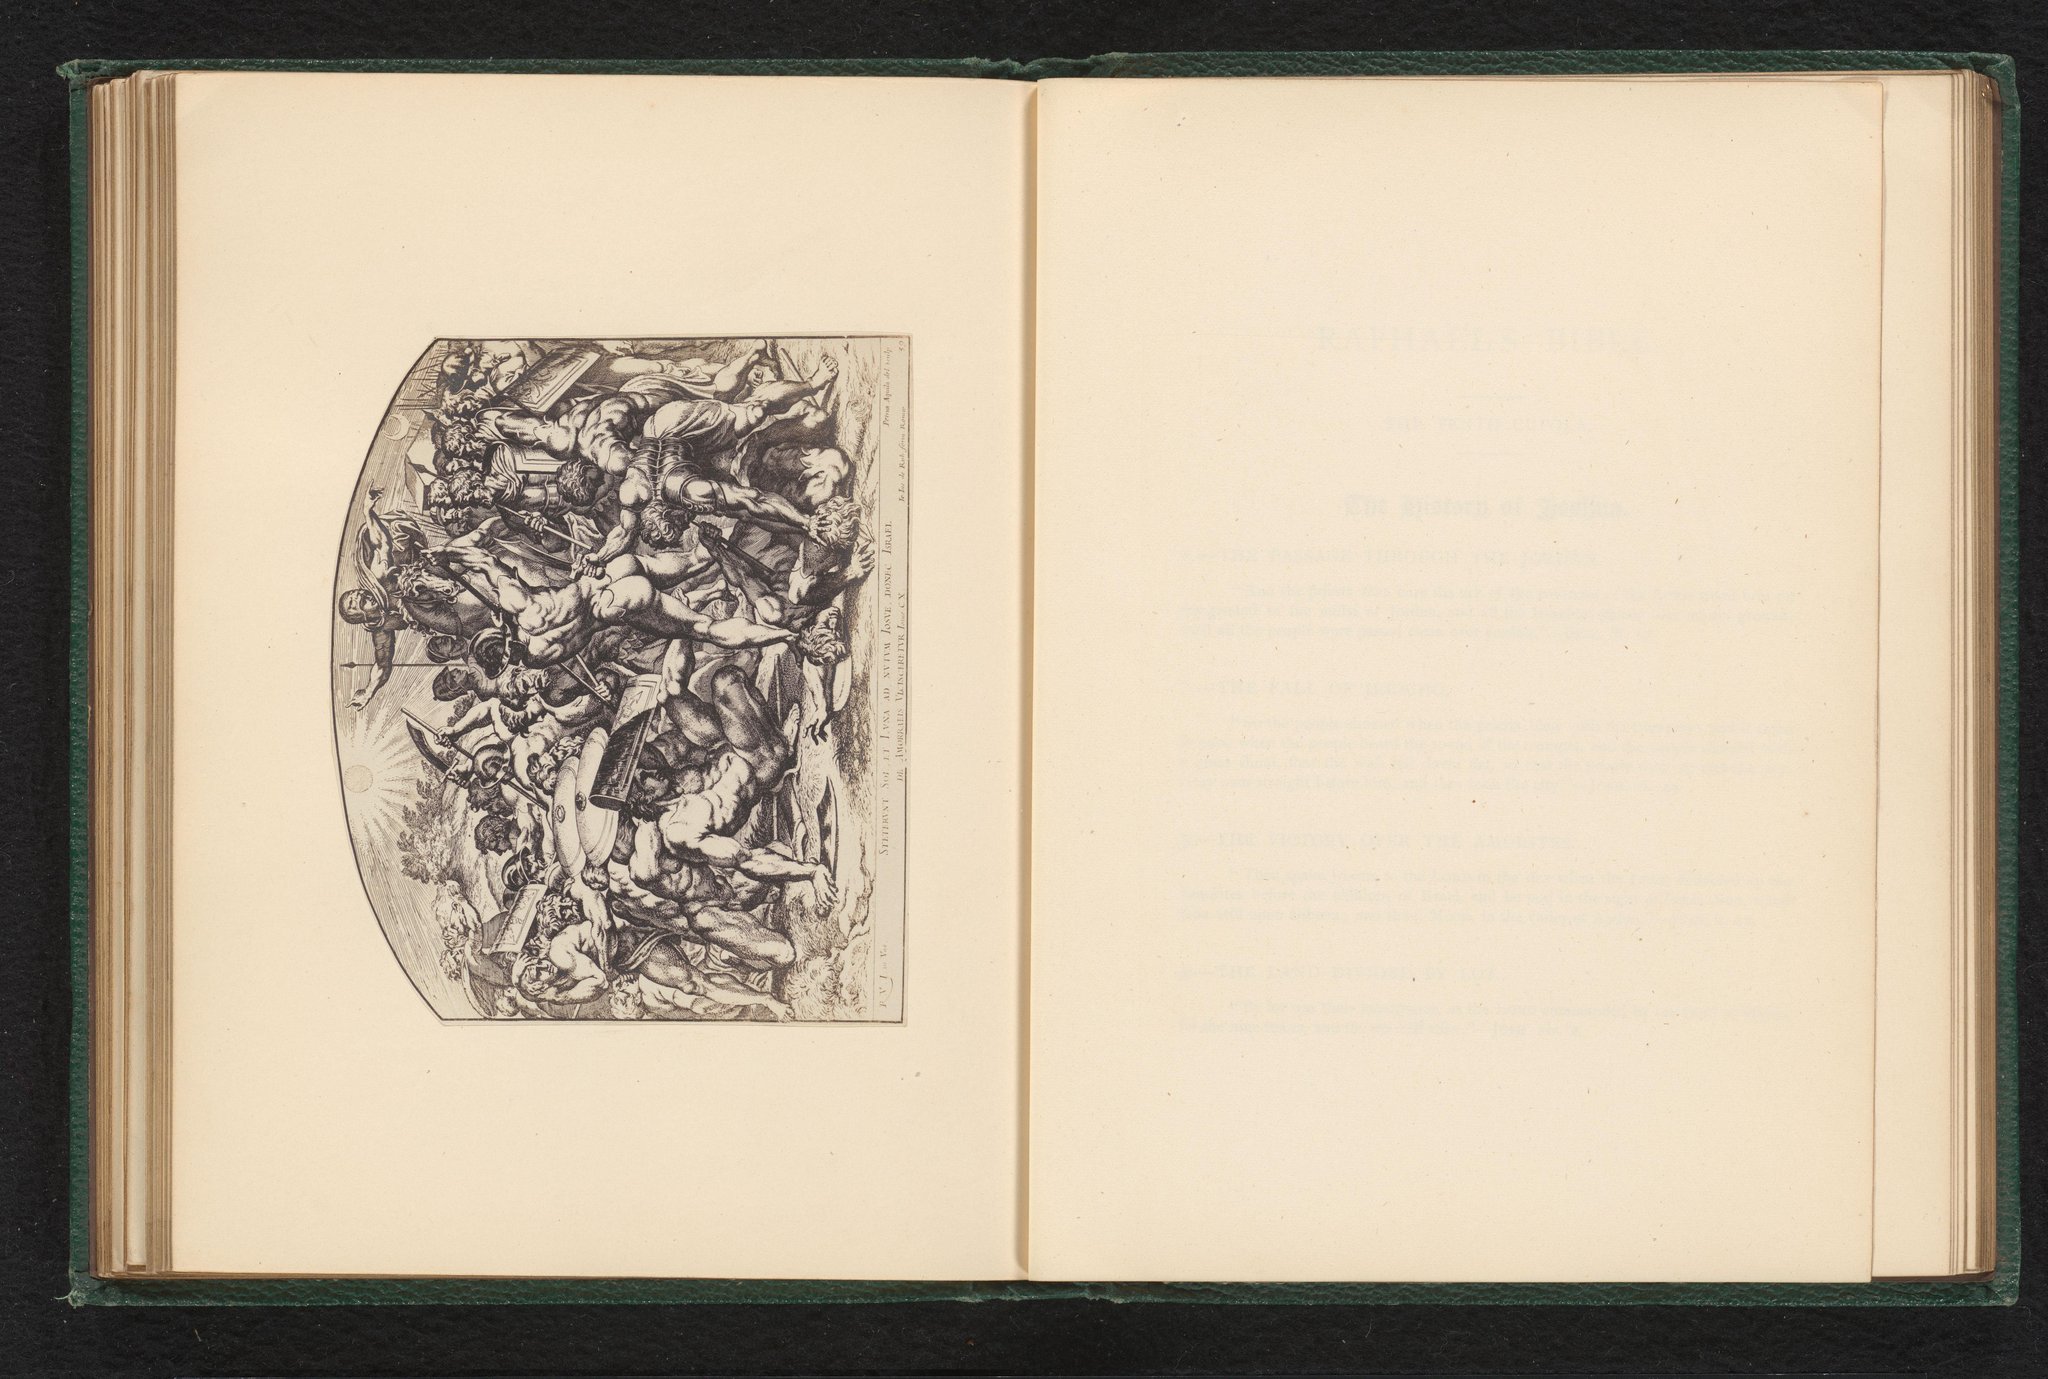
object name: photograph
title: Fotoreproductie van een prent naar een fresco door Rafaël van de overwinning van Joshua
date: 1863-1868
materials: paper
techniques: albumen print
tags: joshua orders the sun and the moon to stand still over gibeon and aijalon until the amorites who had besieged the city of gibeon are routed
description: Foto op ongenummerde pagina na pagina 94.